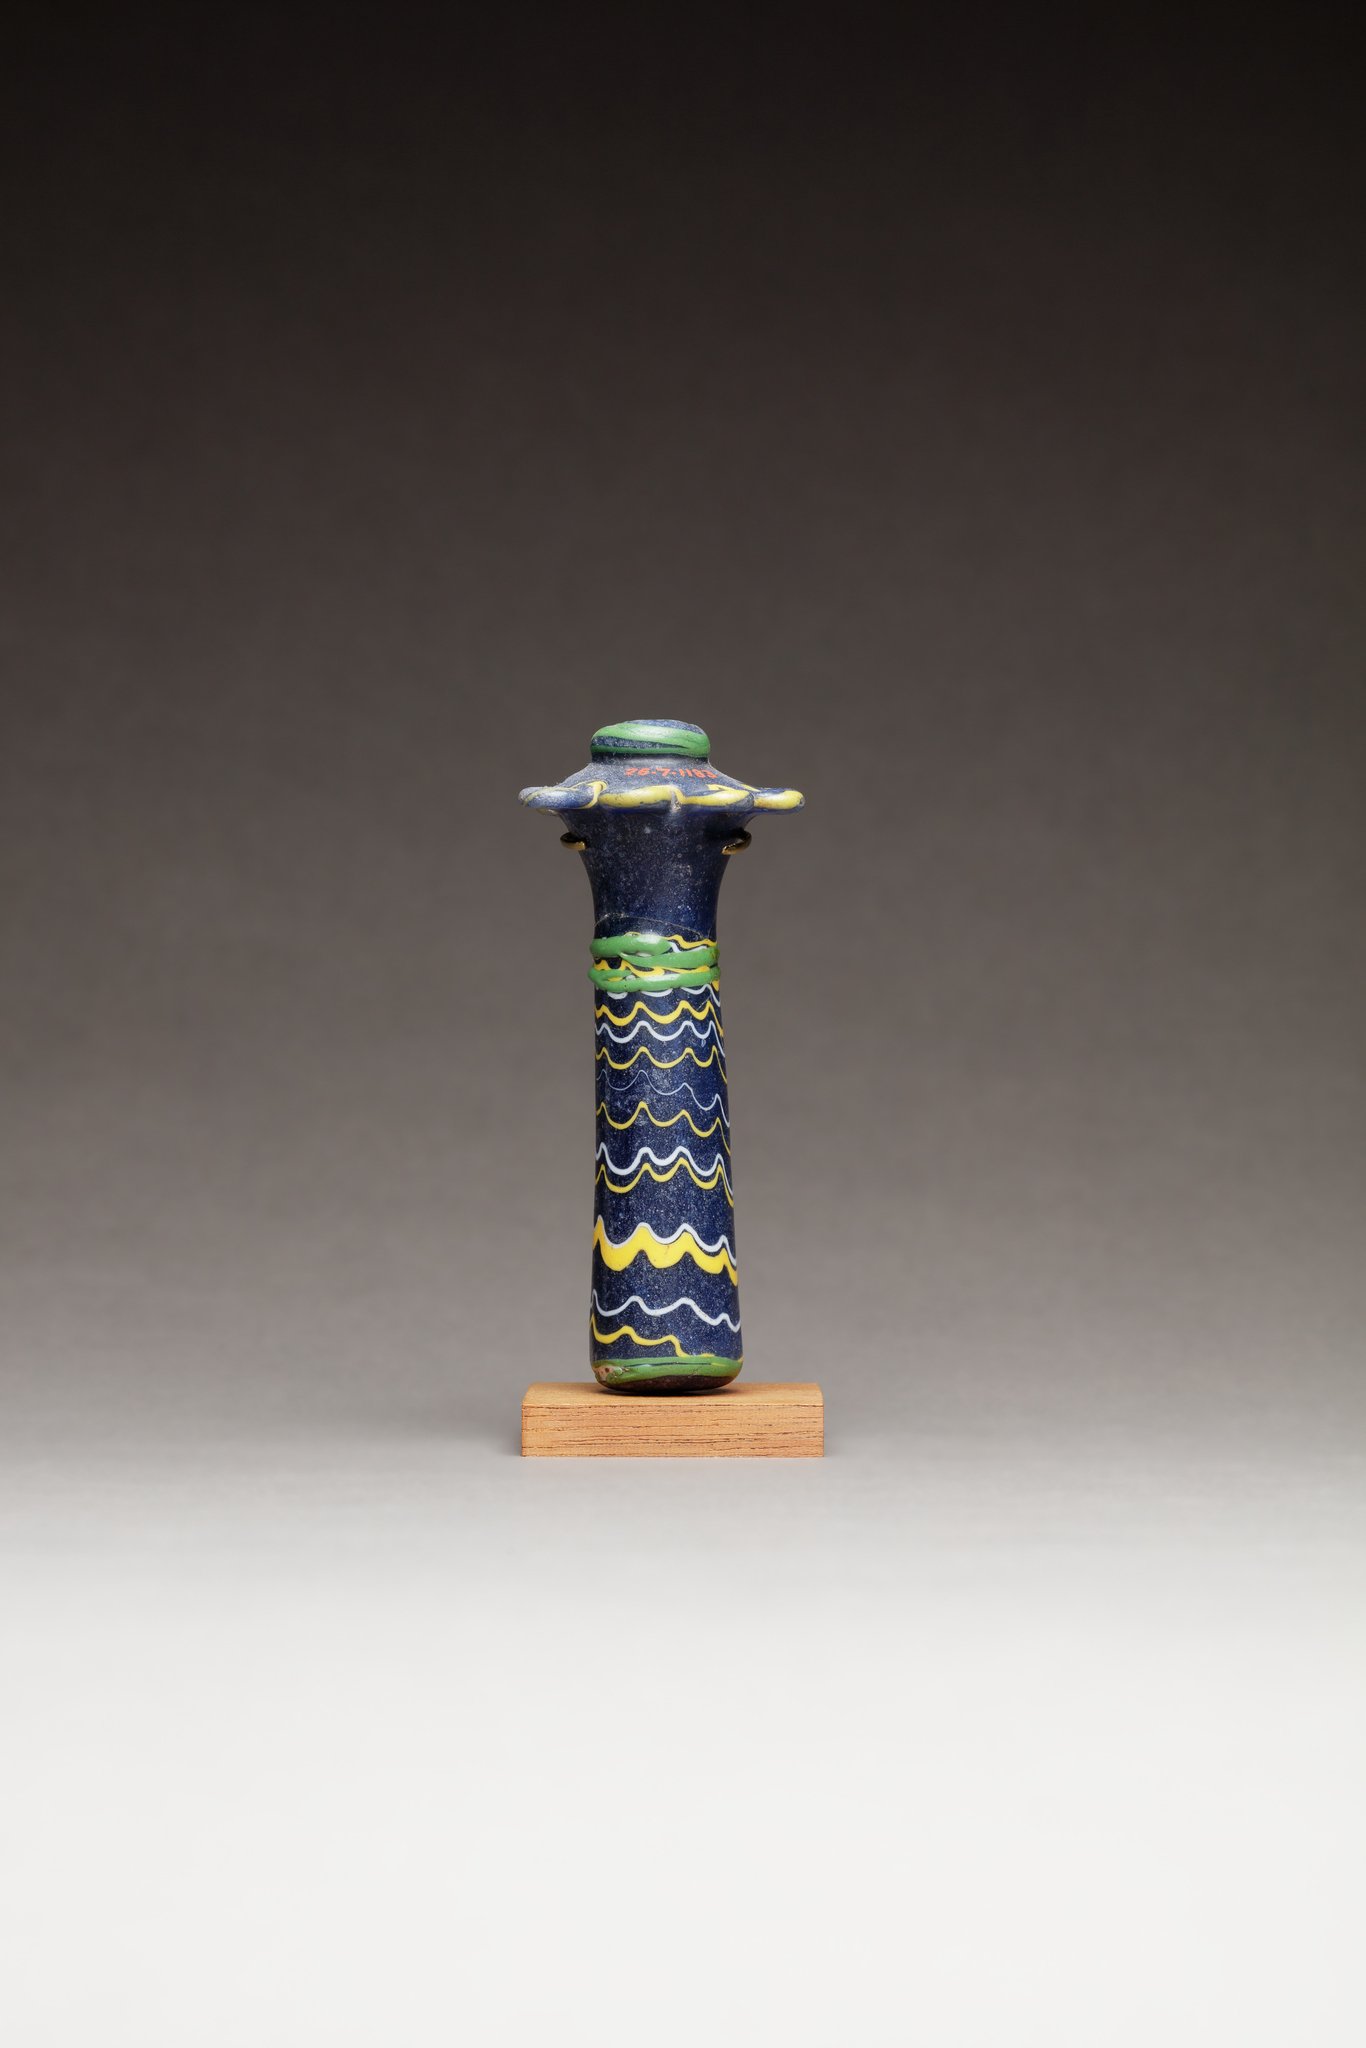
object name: kohl tube, papyrus column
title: Kohl Tube in the Form of a Papyrus Column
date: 1400-1352 BCE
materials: glass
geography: egypt